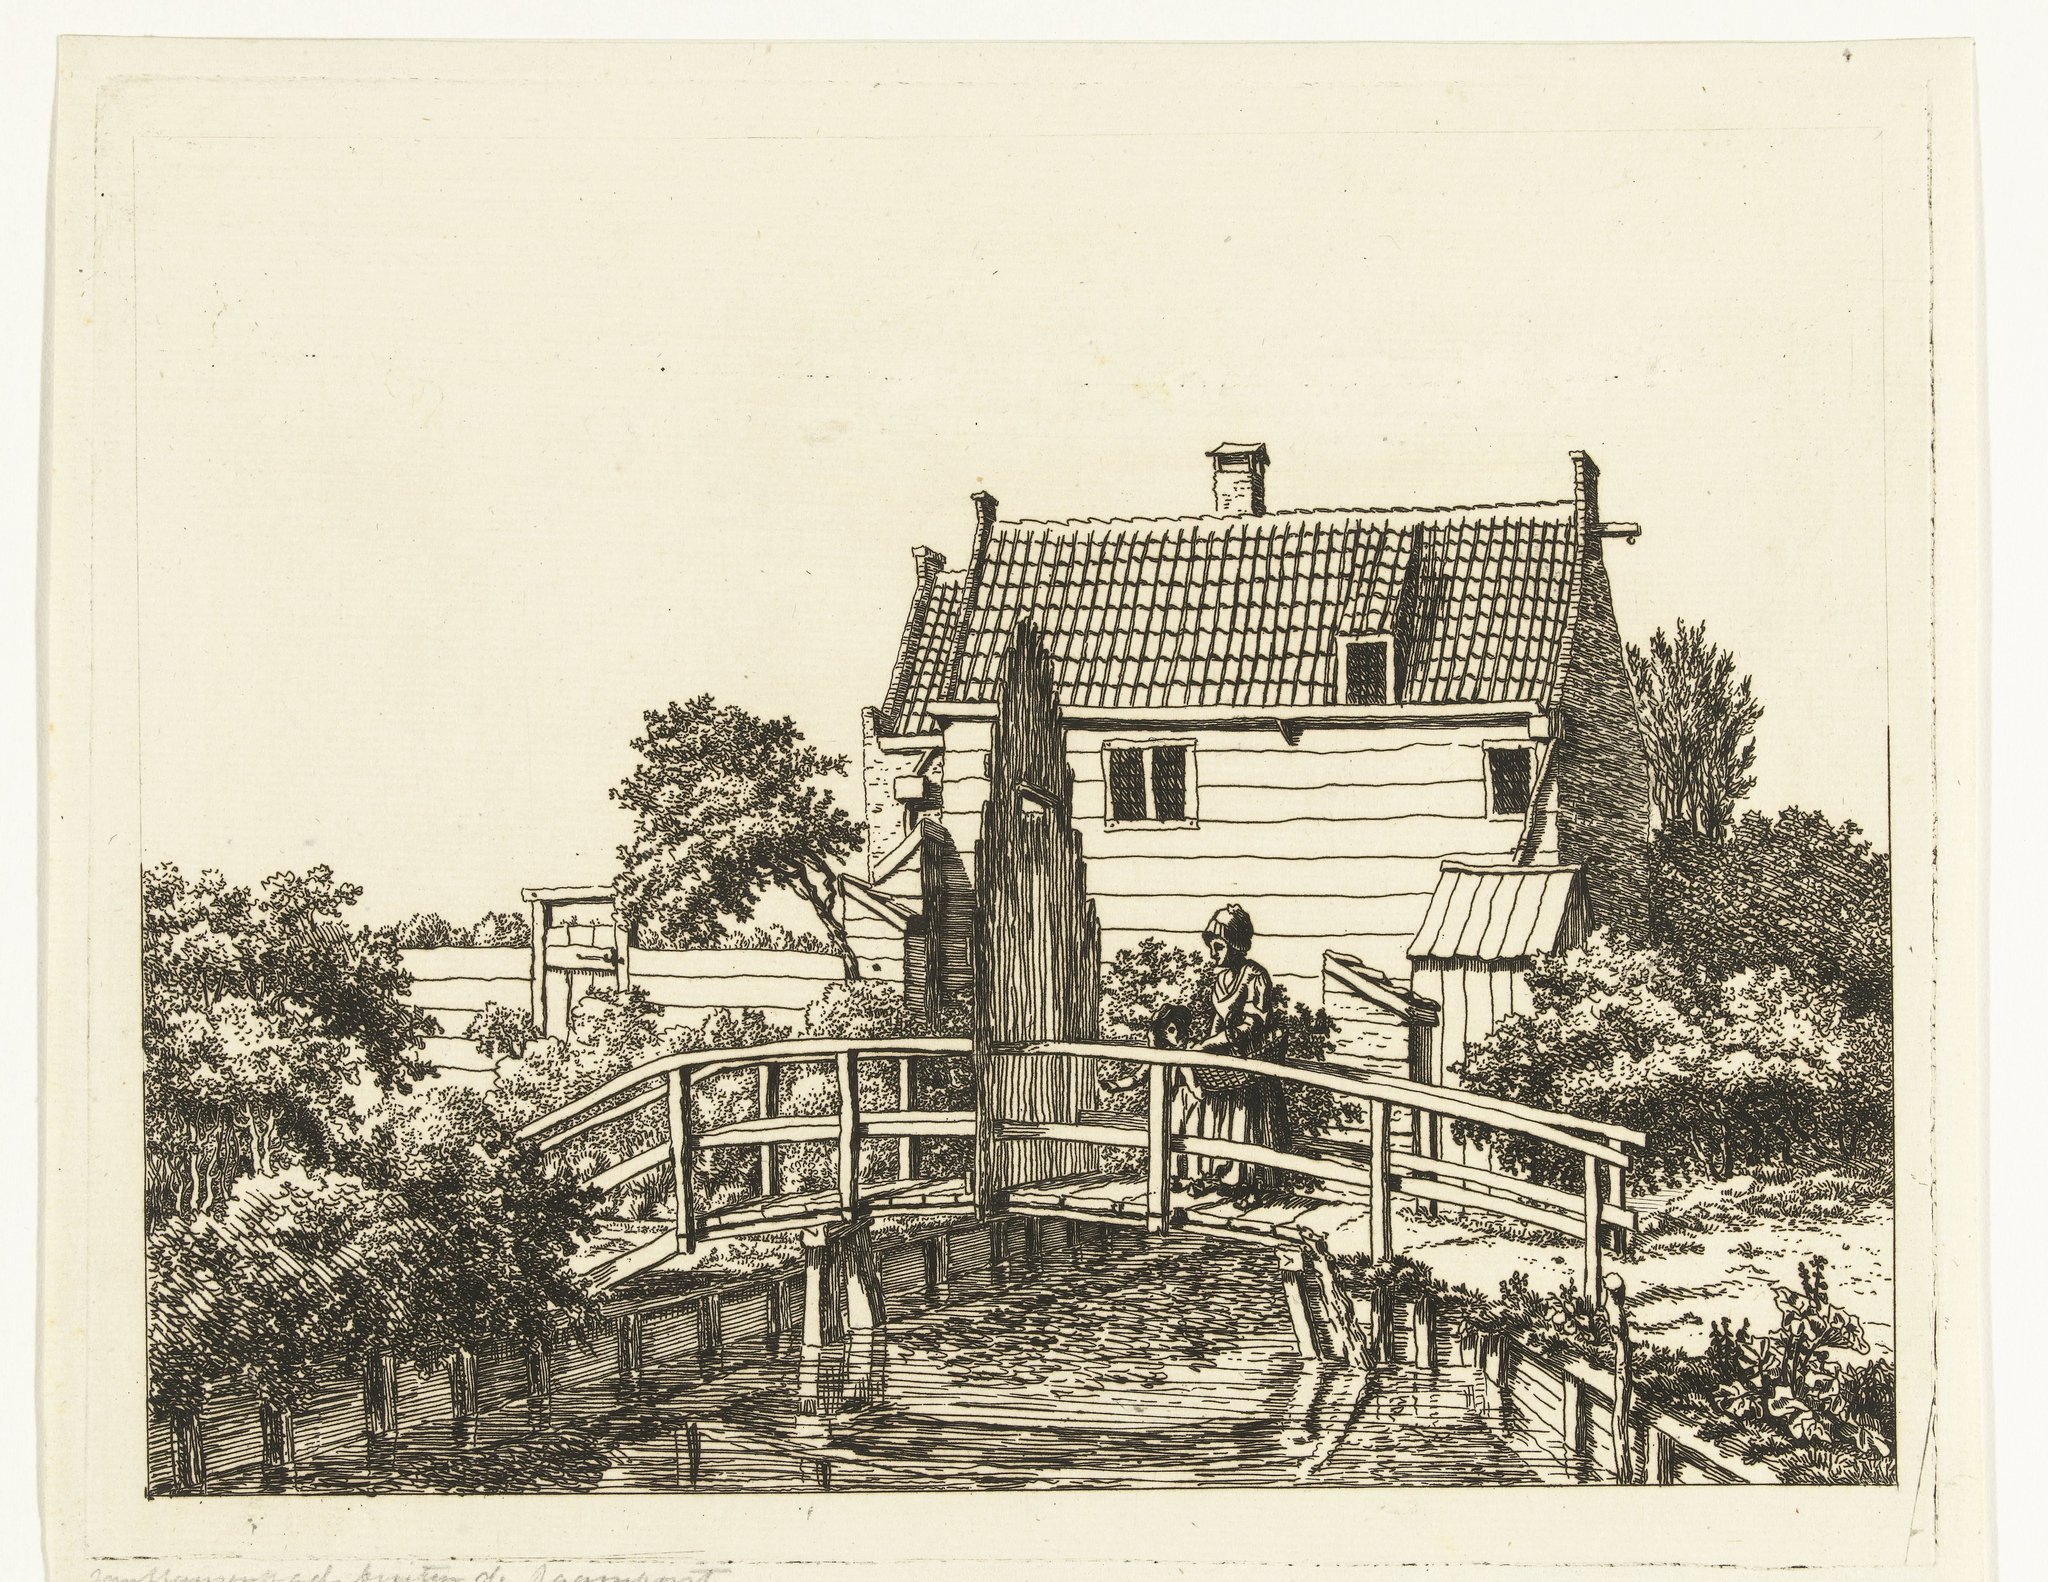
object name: print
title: Vrouw met kind op een brug bij een gesloten hek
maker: anthonie van den bos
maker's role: draughtsman, print maker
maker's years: 1763-1838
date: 1778-1838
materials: paper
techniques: etching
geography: netherlands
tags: bridge with structure, i.e. cover or buildings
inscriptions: collector's mark: Lugt 2228